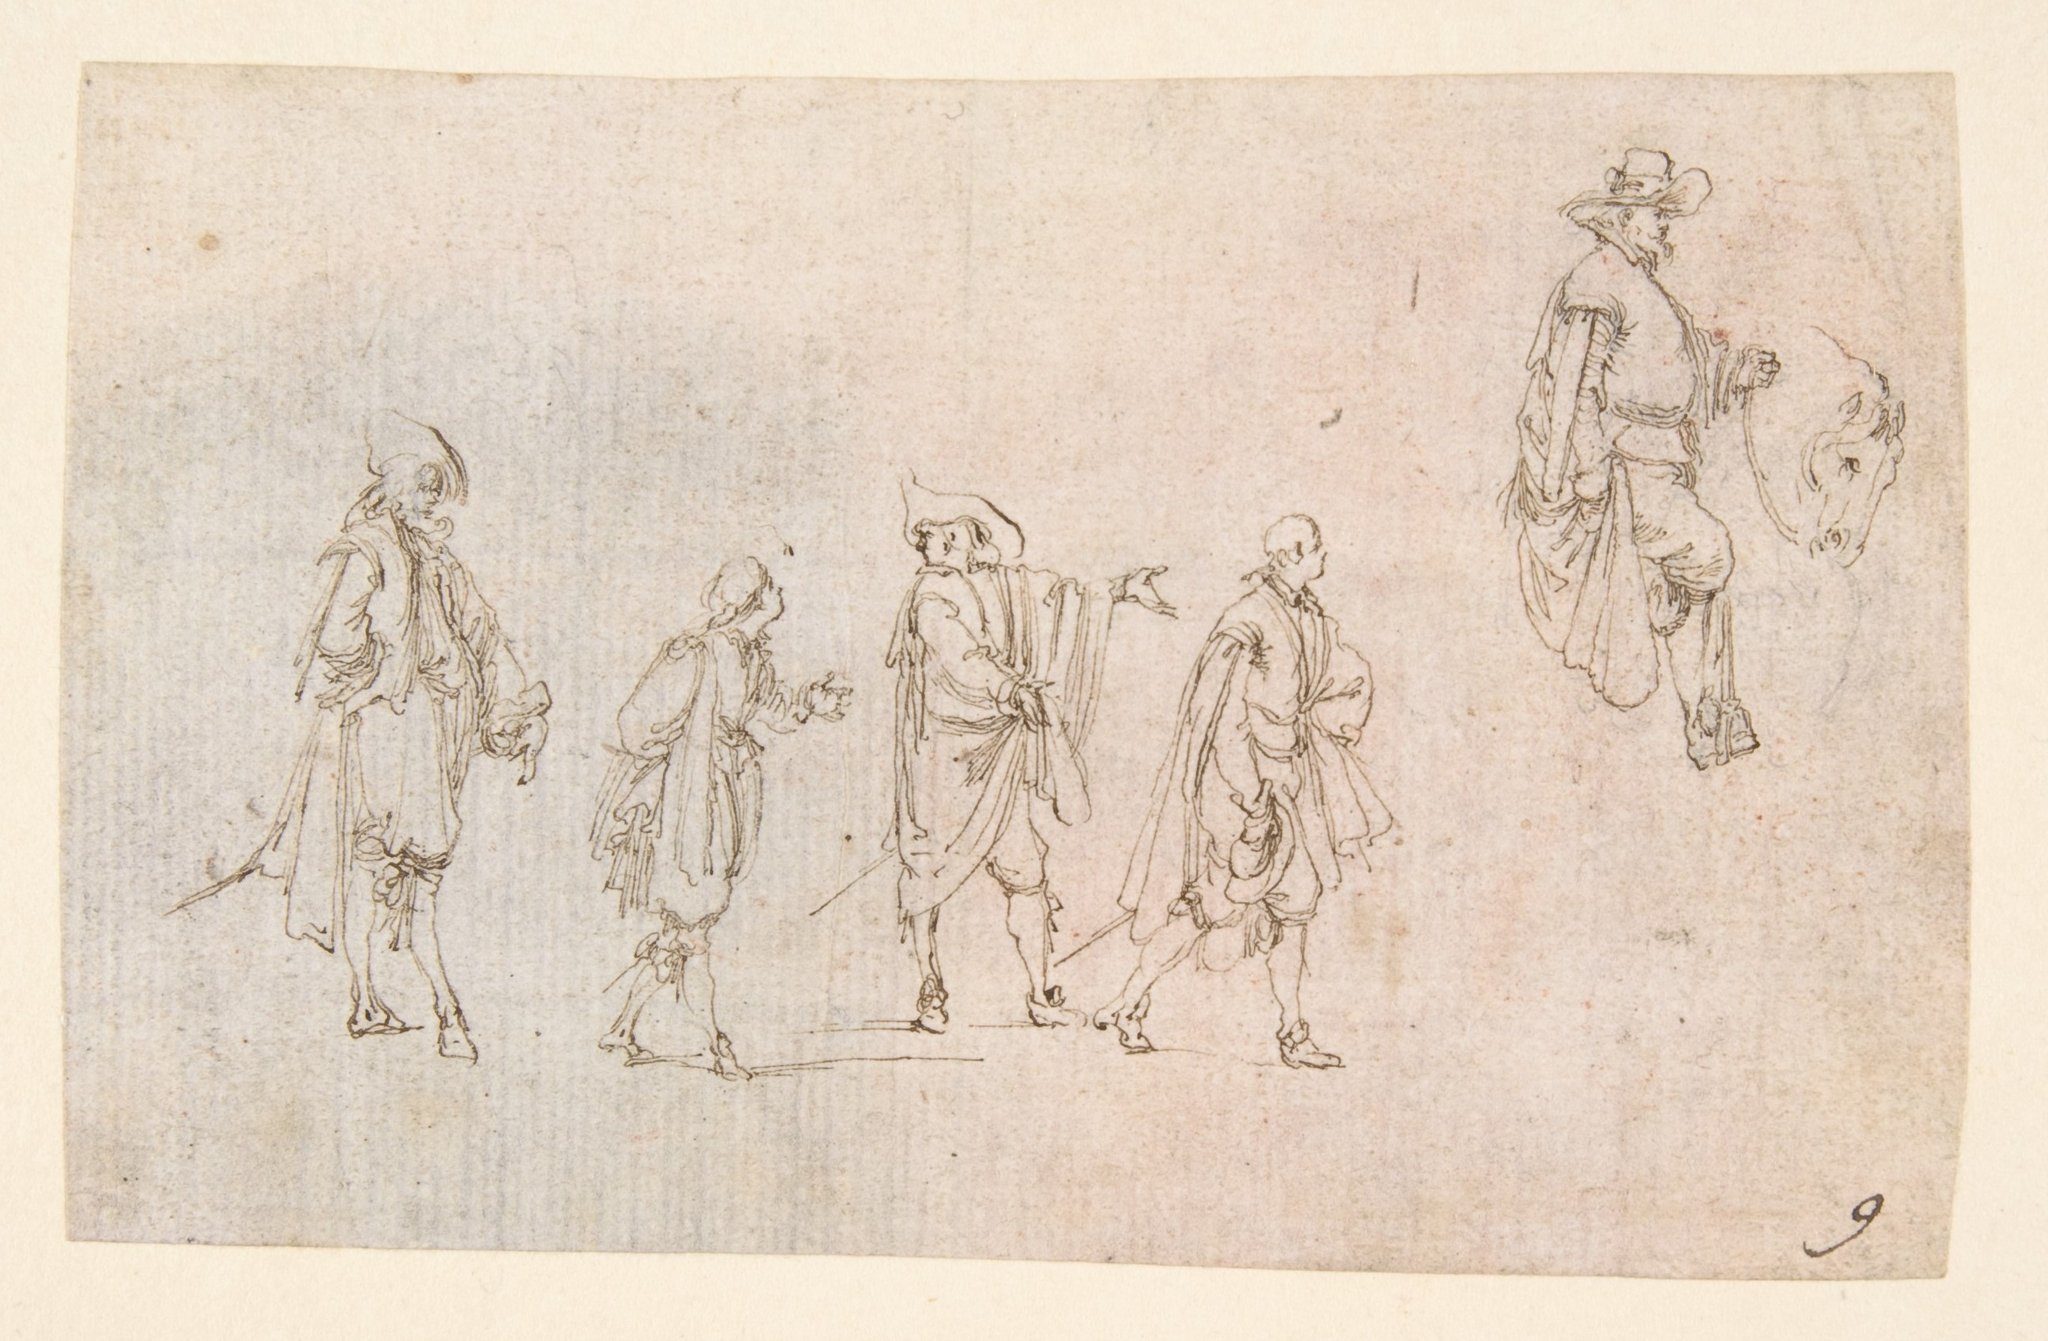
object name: drawing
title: Studies of Cavaliers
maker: stefano della bella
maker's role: artist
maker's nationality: italian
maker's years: 1610-1664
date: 1610-1664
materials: ink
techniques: pen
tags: men,walking